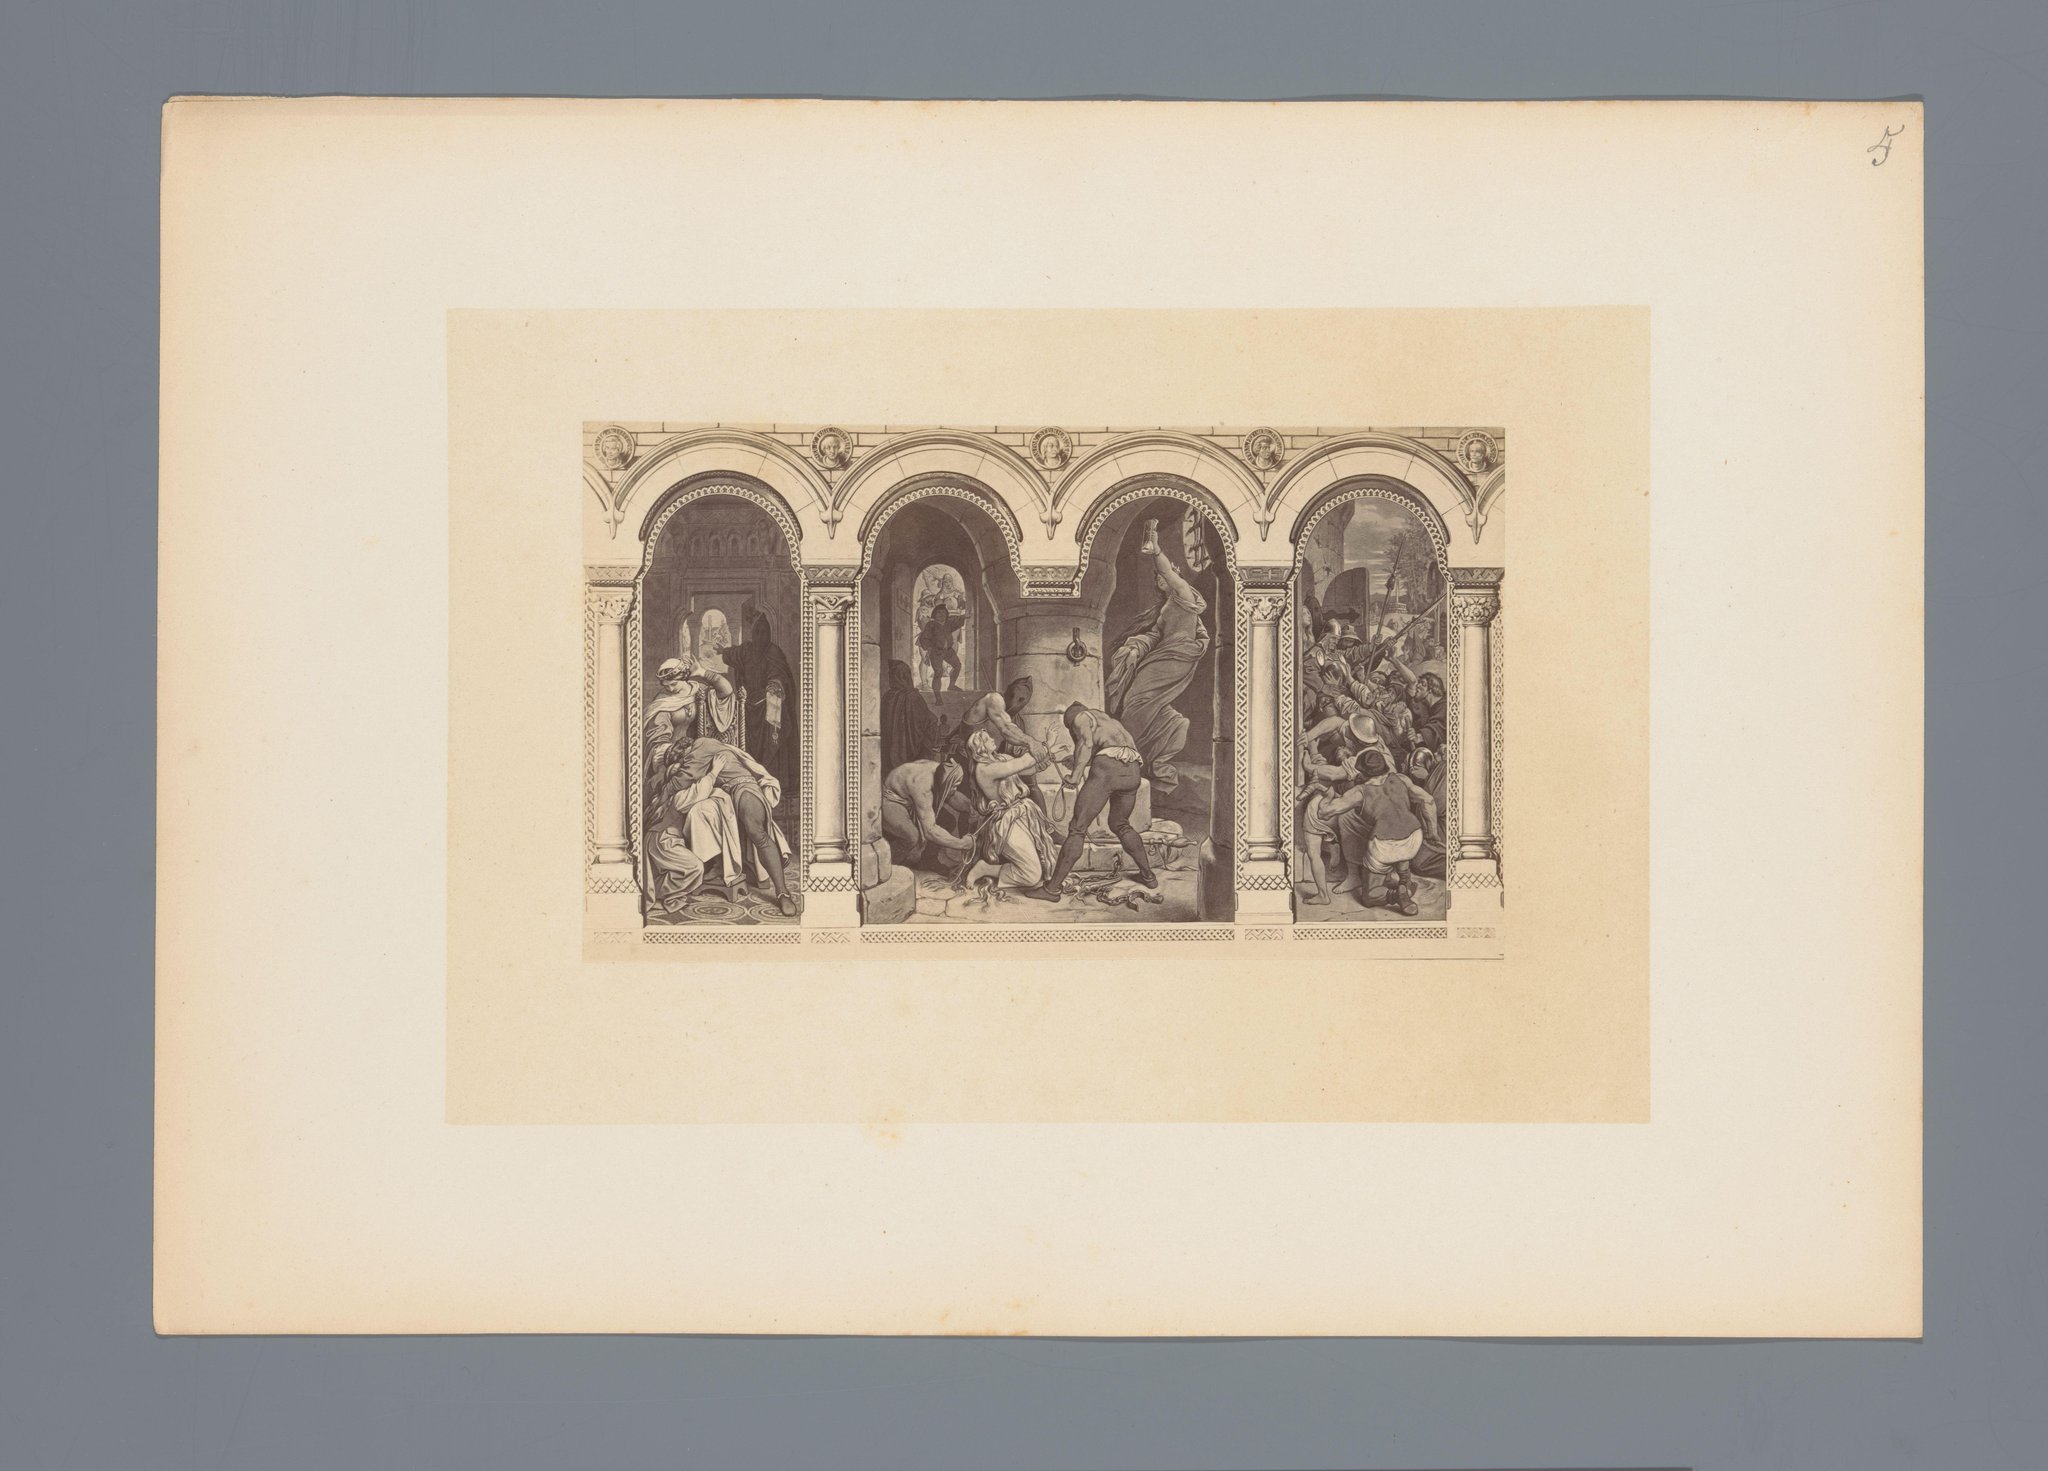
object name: reproduction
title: Fotoreproductie van een scène uit het sprookje Die Sieben Raben van de gebroeders Grimm door Moritz von Schwind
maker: joseph albert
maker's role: printer, publisher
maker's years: 1825-1886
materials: photographic support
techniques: albumen print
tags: tales and fairy tales, abducting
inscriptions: number: ‘5’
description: Deze foto maakt deel uit van een omslag met zes foto's en een tekstblad.